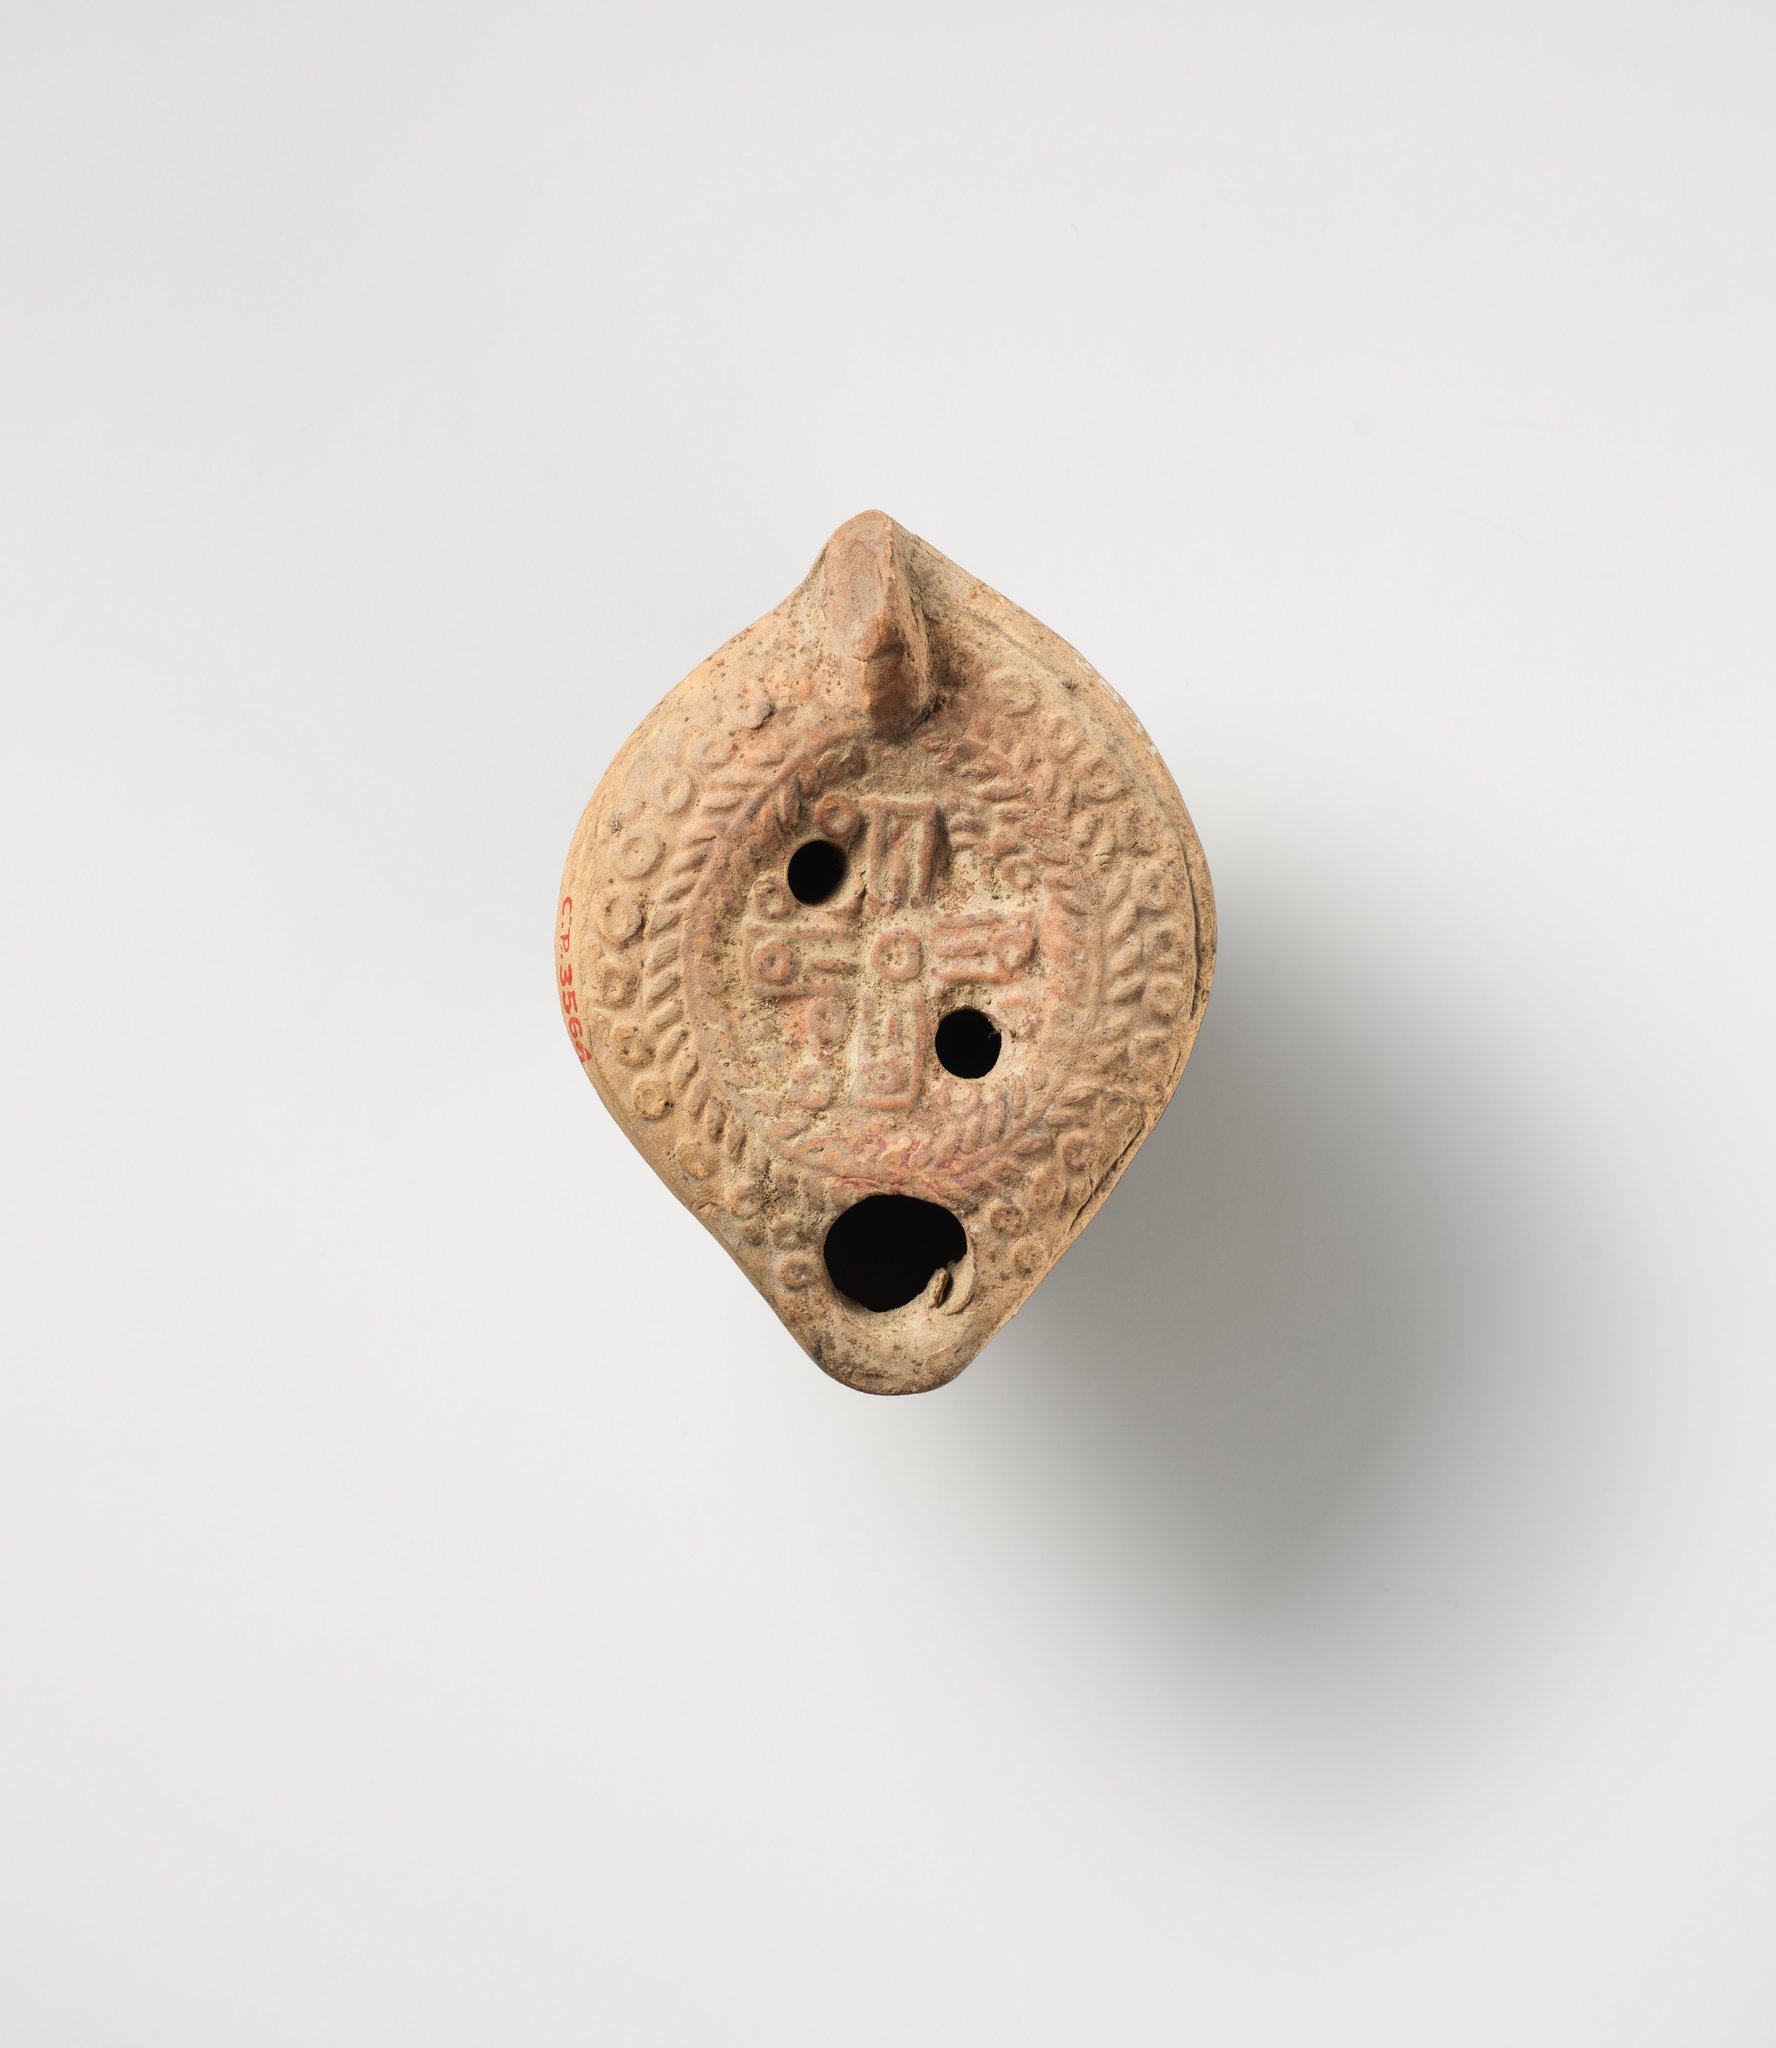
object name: lamp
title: Terracotta oil lamp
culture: roman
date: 401-500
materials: terracotta